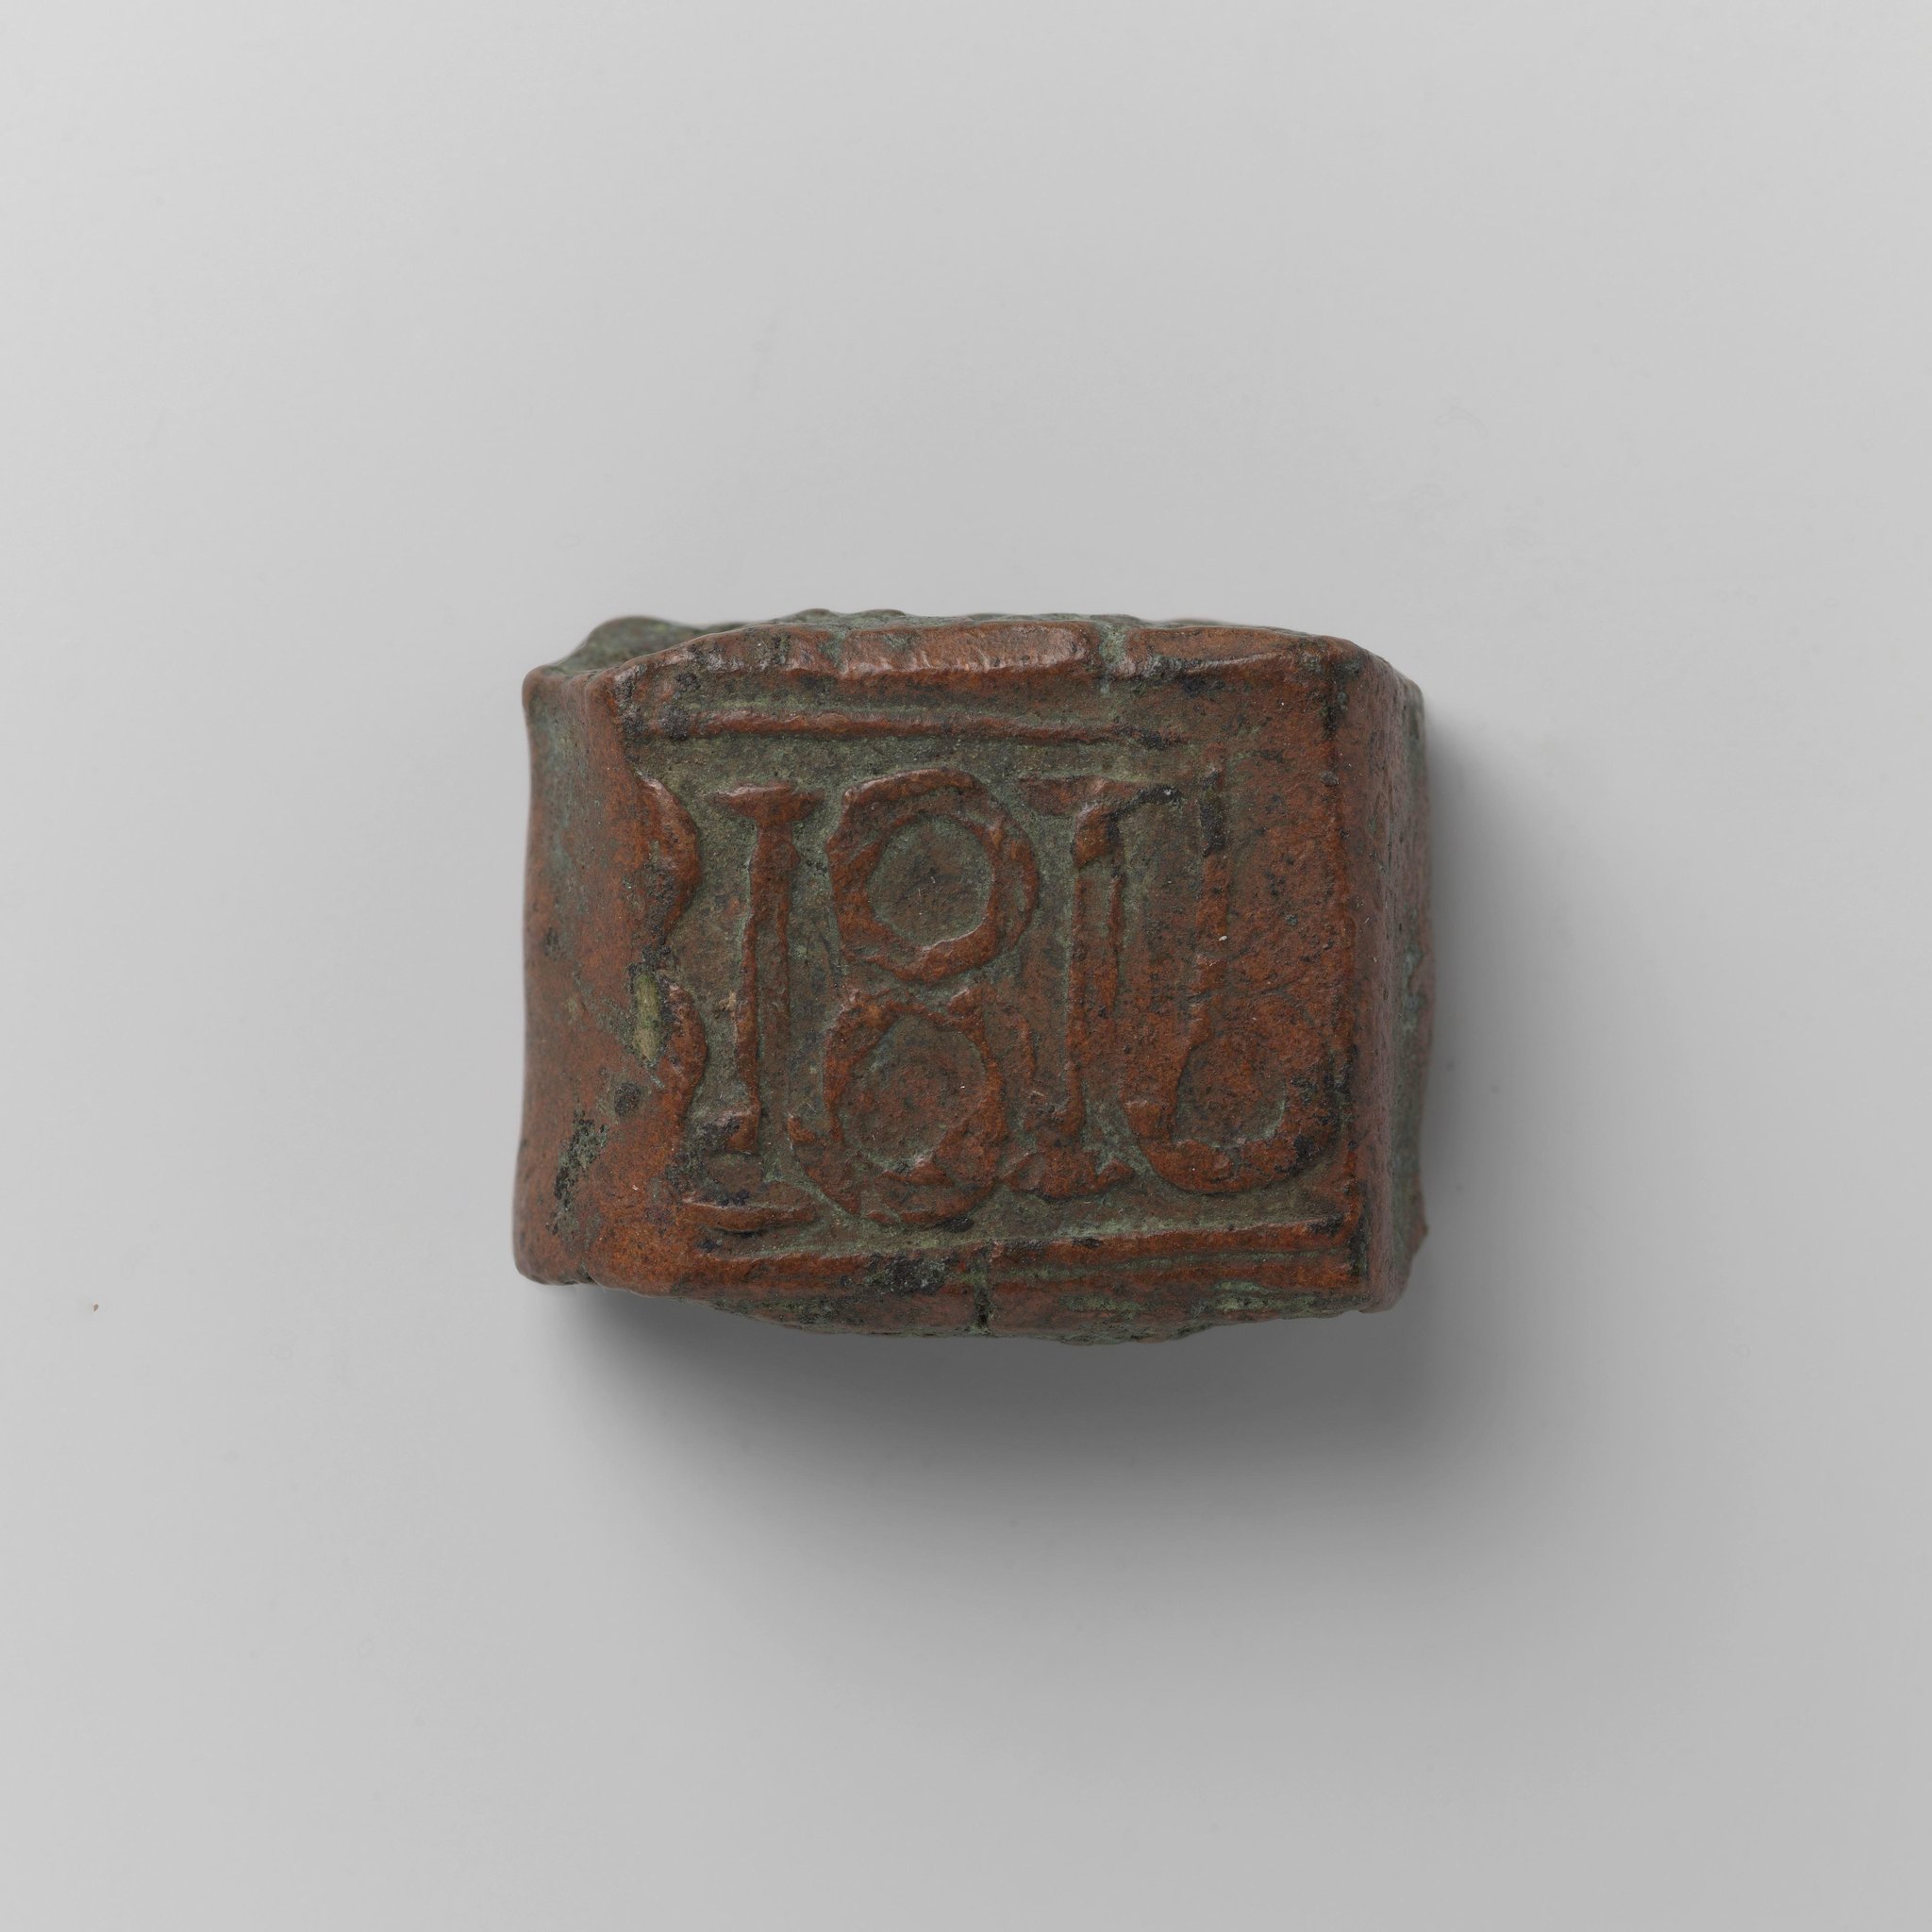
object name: coin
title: Bonk van 1 stuiver van Nederlands Indië,1818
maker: william i of the netherlands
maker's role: koning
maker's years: 1772-1843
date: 1818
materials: copper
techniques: striking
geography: surabaya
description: Koperen rechthoekige munt. Voorzijde: binnen een rechthoekige lijst waarde-aanduiding 1 St. Keerzijde: binnen een rechthoekige lijst jaartal.